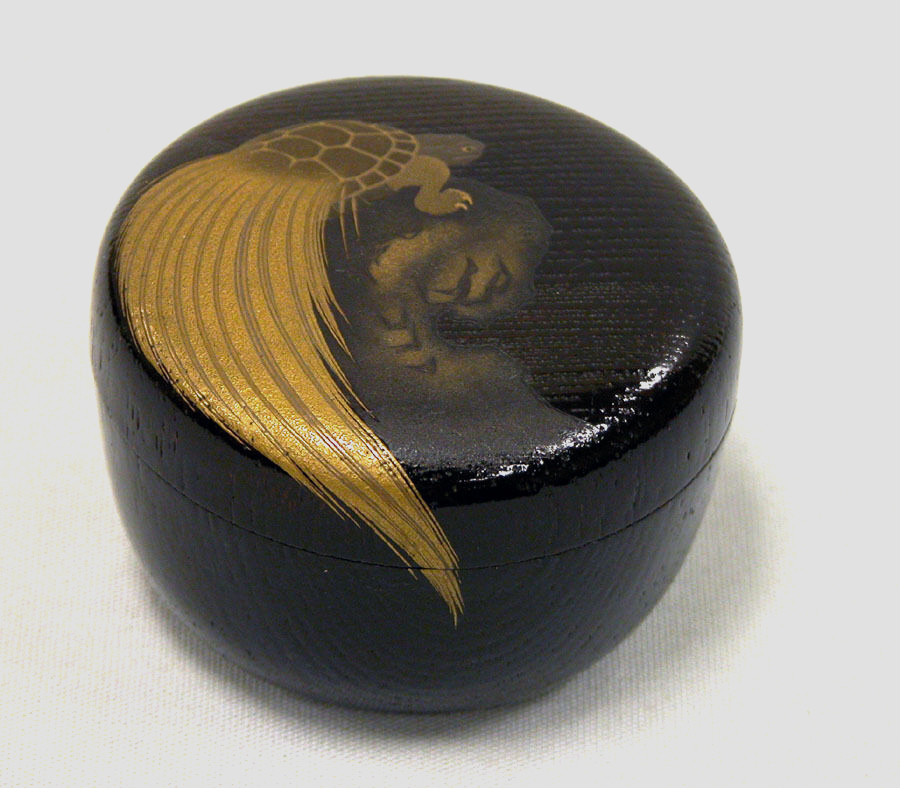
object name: tea caddy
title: Tea Caddy with Design of Turtle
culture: japanese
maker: shibata zeshin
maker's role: artist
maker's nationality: japanese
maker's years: 1807-1891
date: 1801-1900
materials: gold, lacquer, wood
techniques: maki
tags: turtles